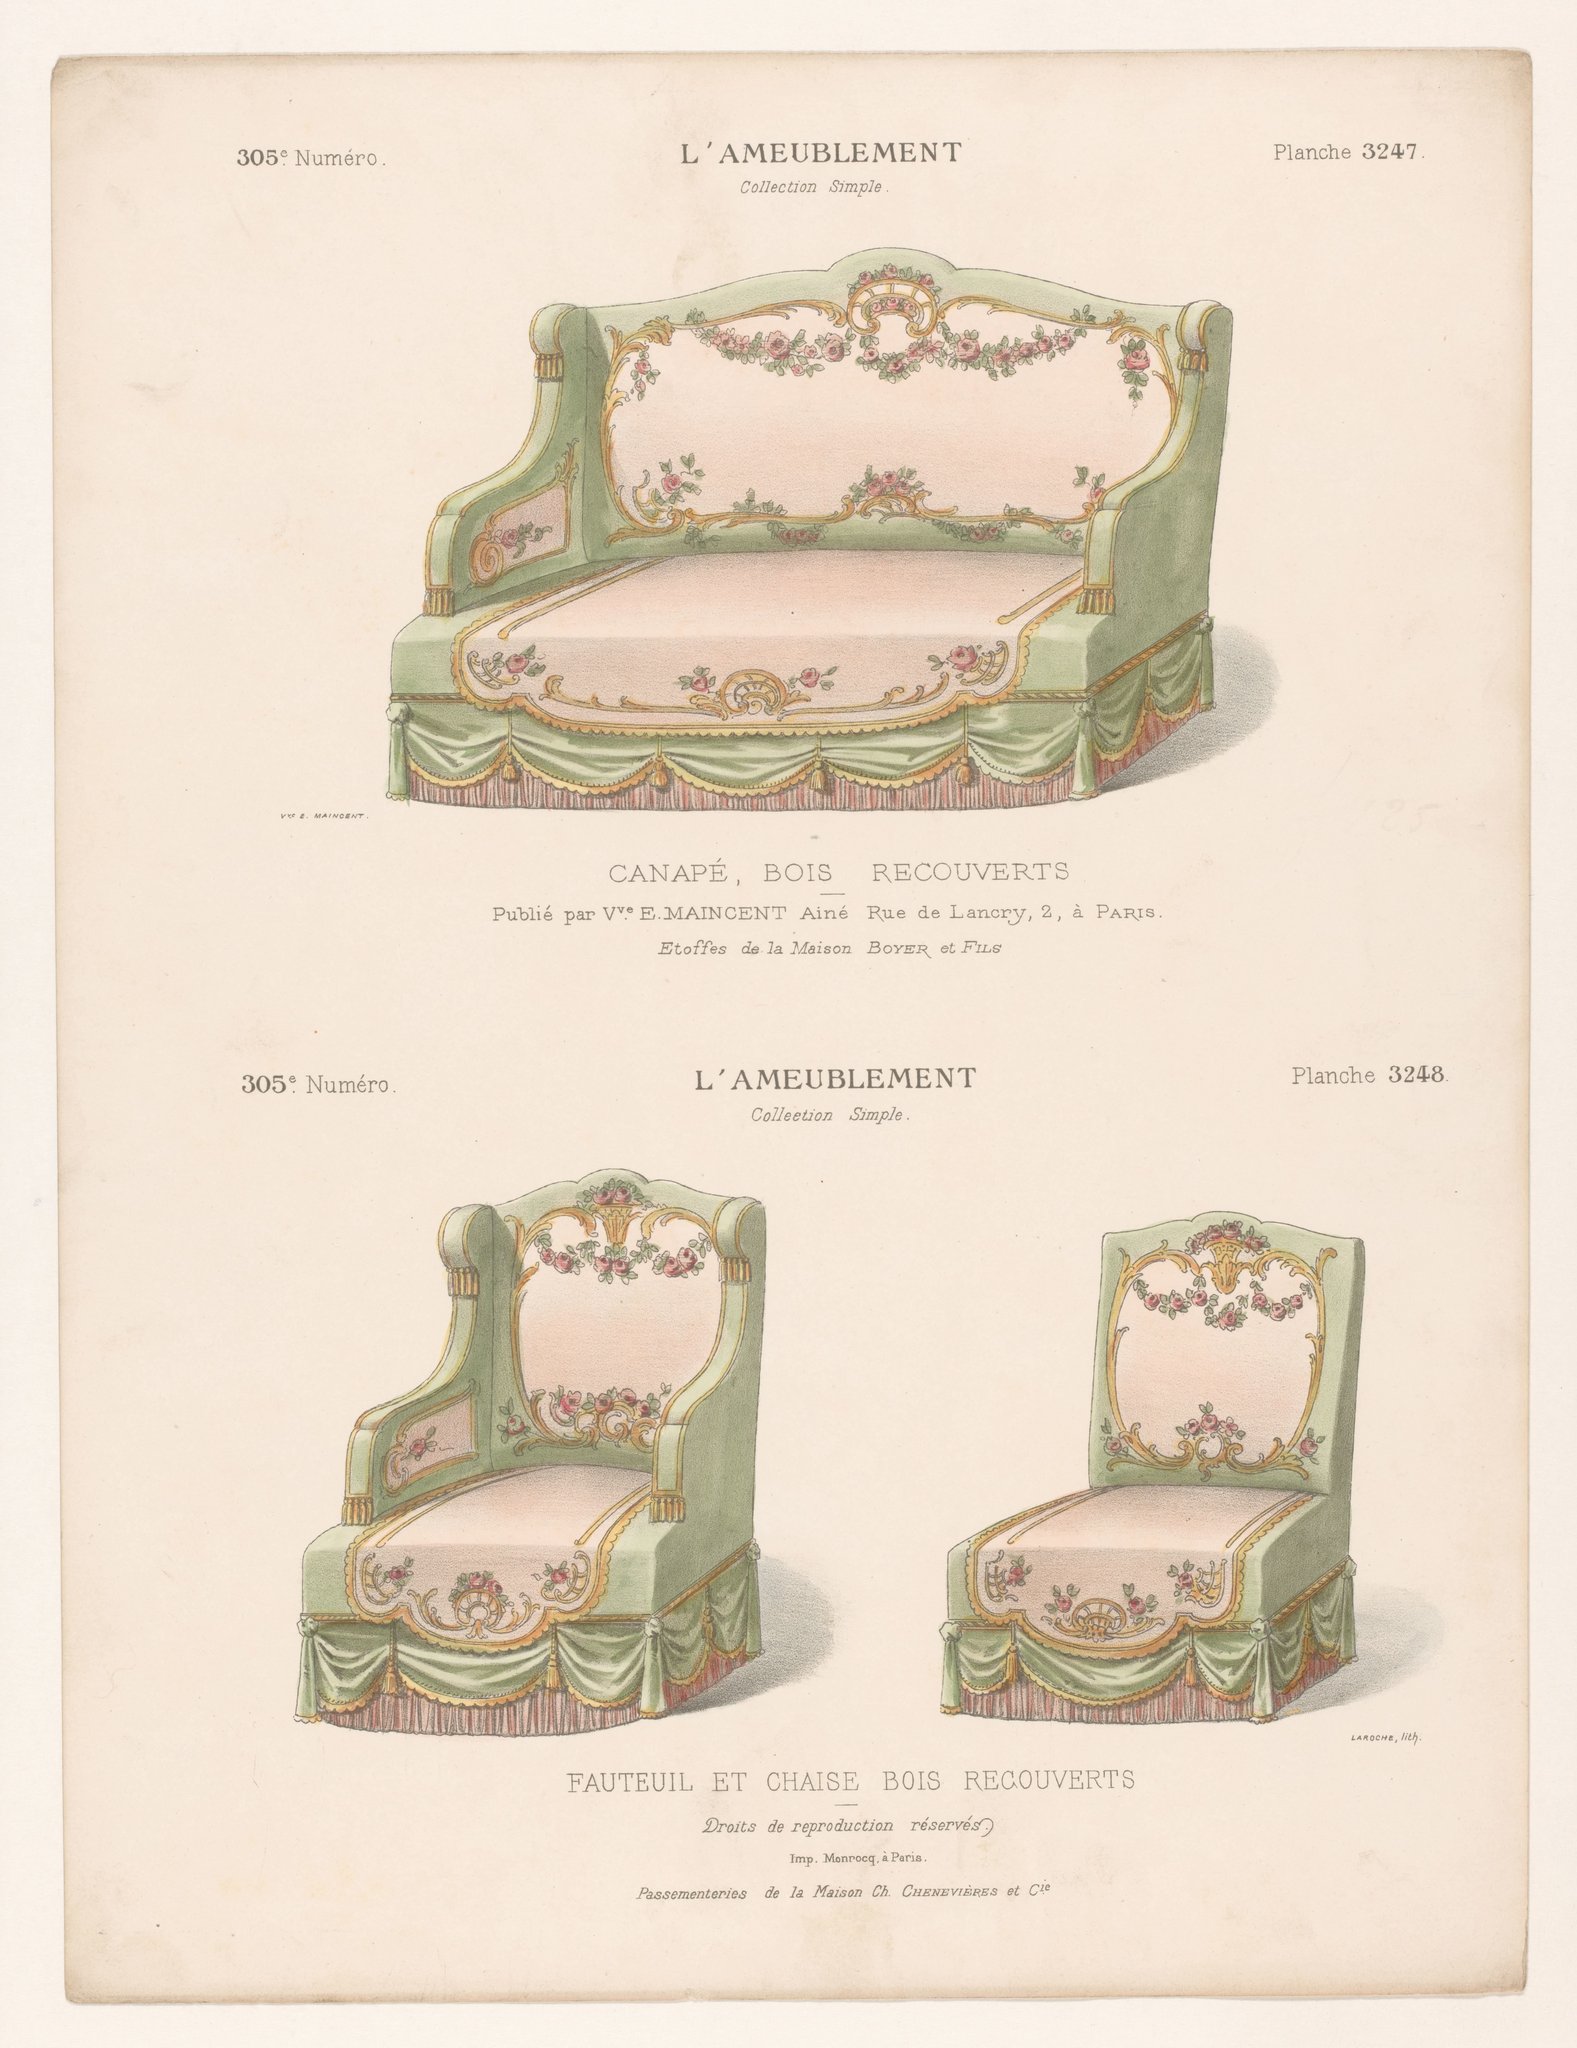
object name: print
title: L'ameublement / Collection simple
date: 1895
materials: paper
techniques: hand coloring, lithograph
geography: paris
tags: seating furniture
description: Een canapé, fauteuil en een stoel. Prent uit 305e nummer (livraison).